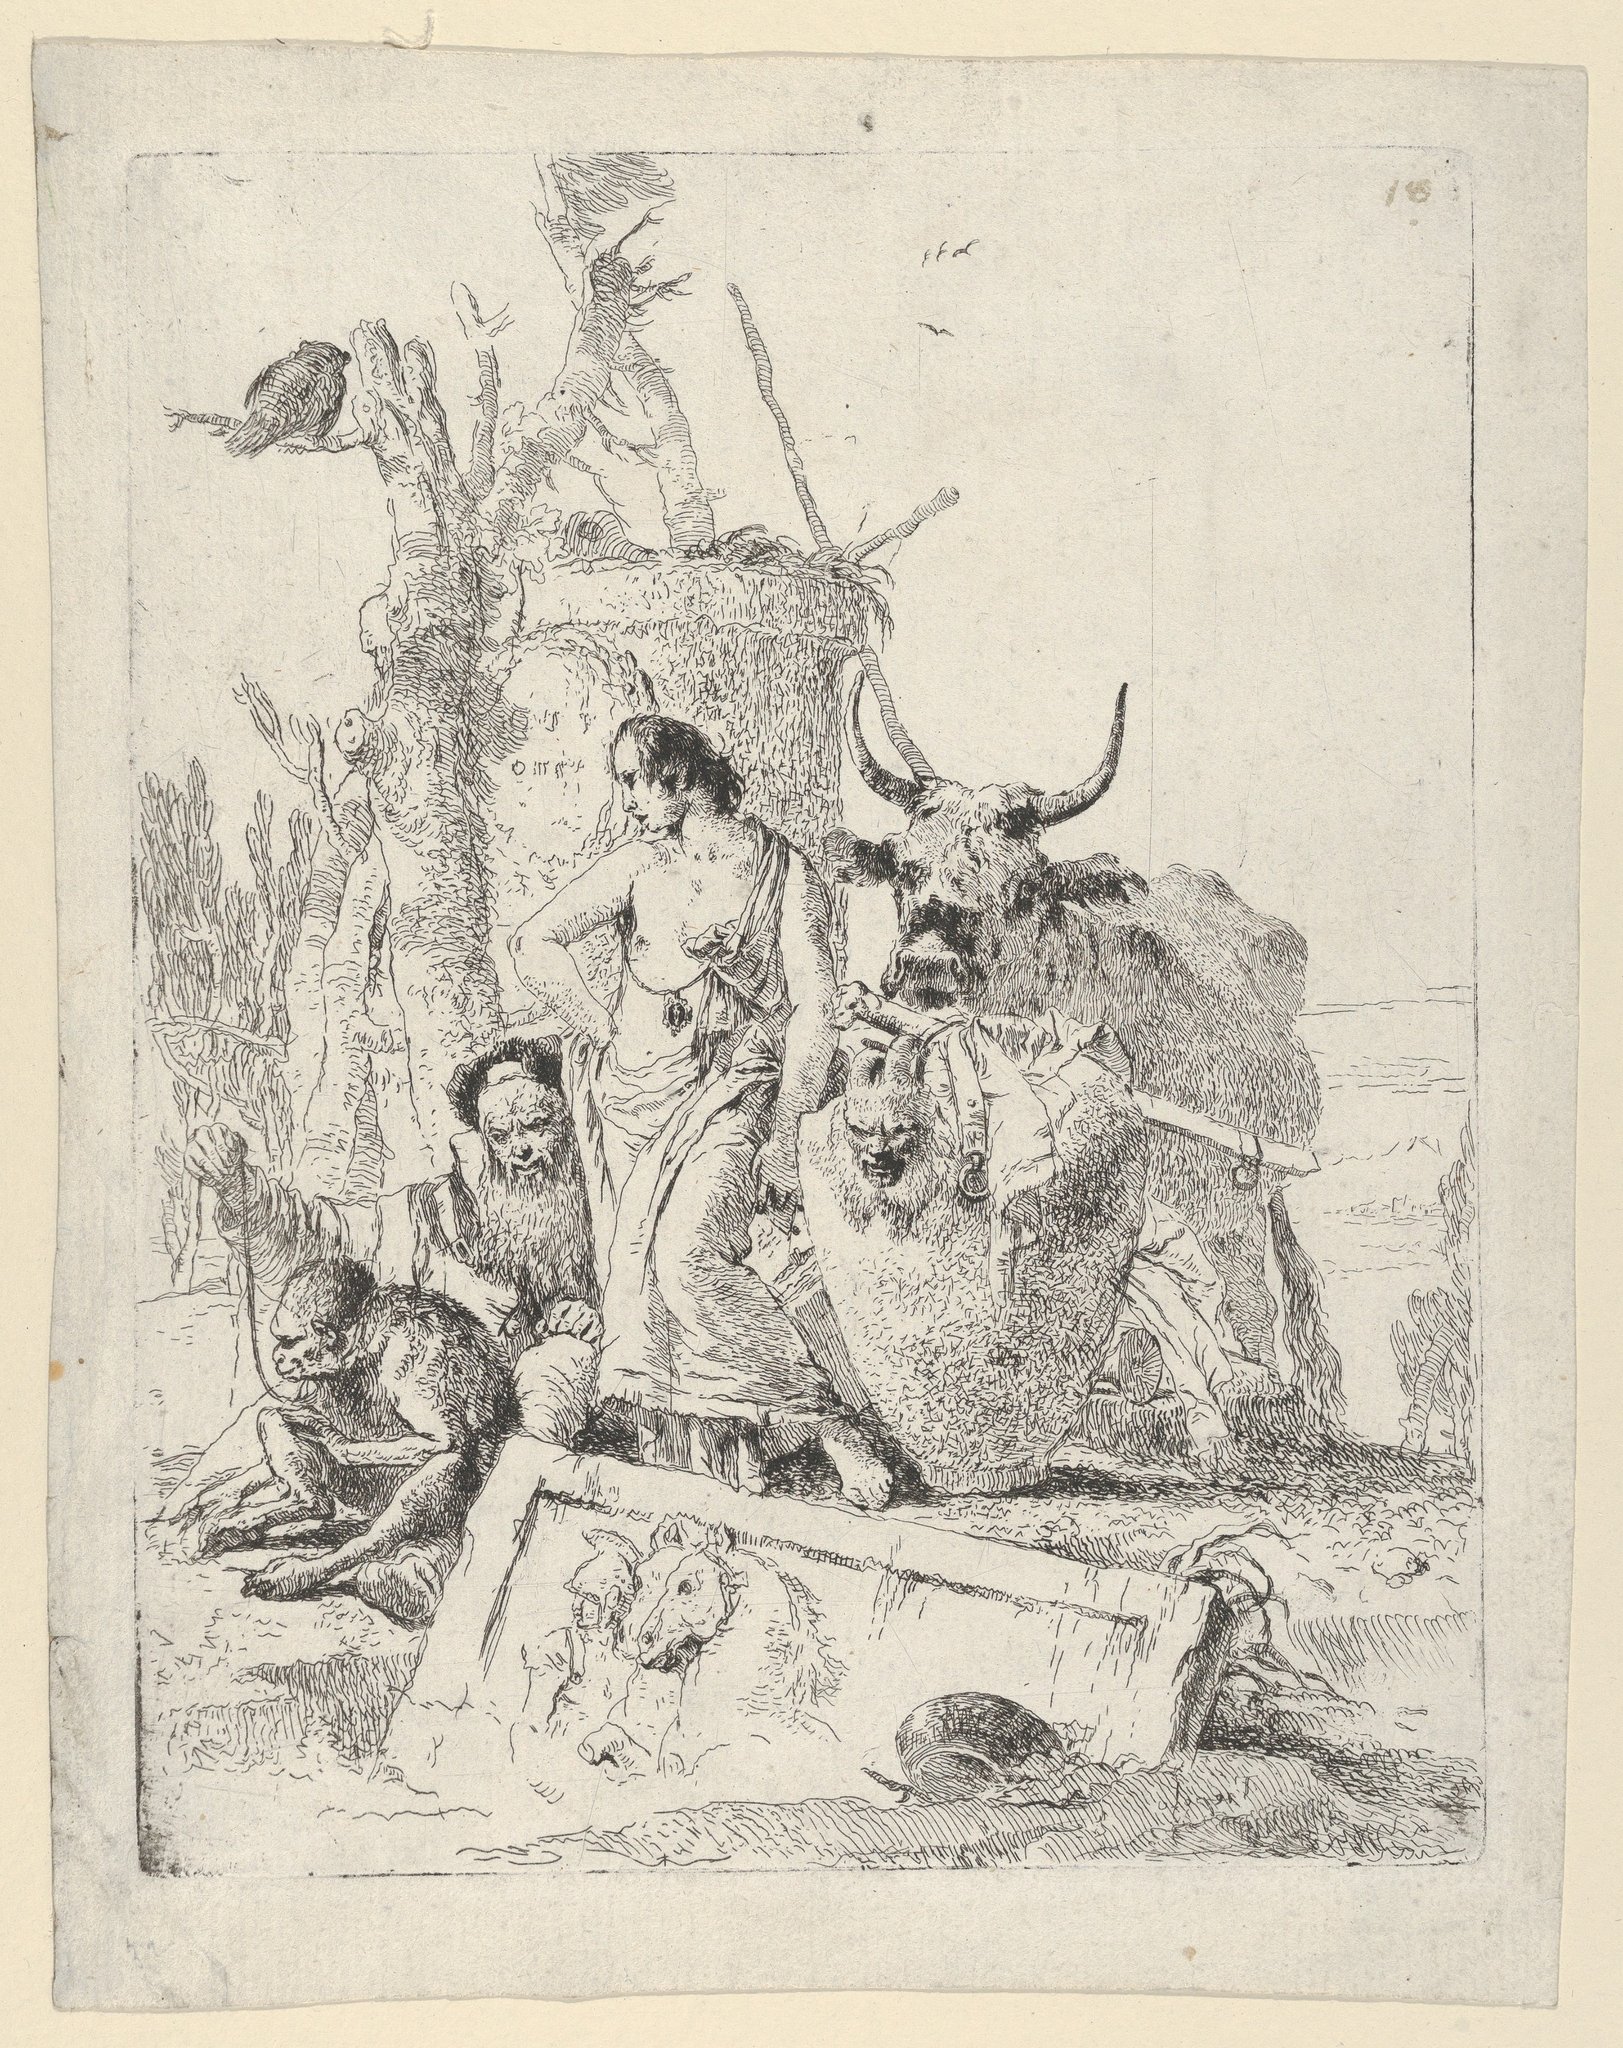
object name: print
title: Young Shepherdess and old man with a Monkey, from the Scherzi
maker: giovanni battista tiepolo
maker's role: artist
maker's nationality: italian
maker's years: 1696-1770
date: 1740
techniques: etching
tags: men,women,bulls,monkeys